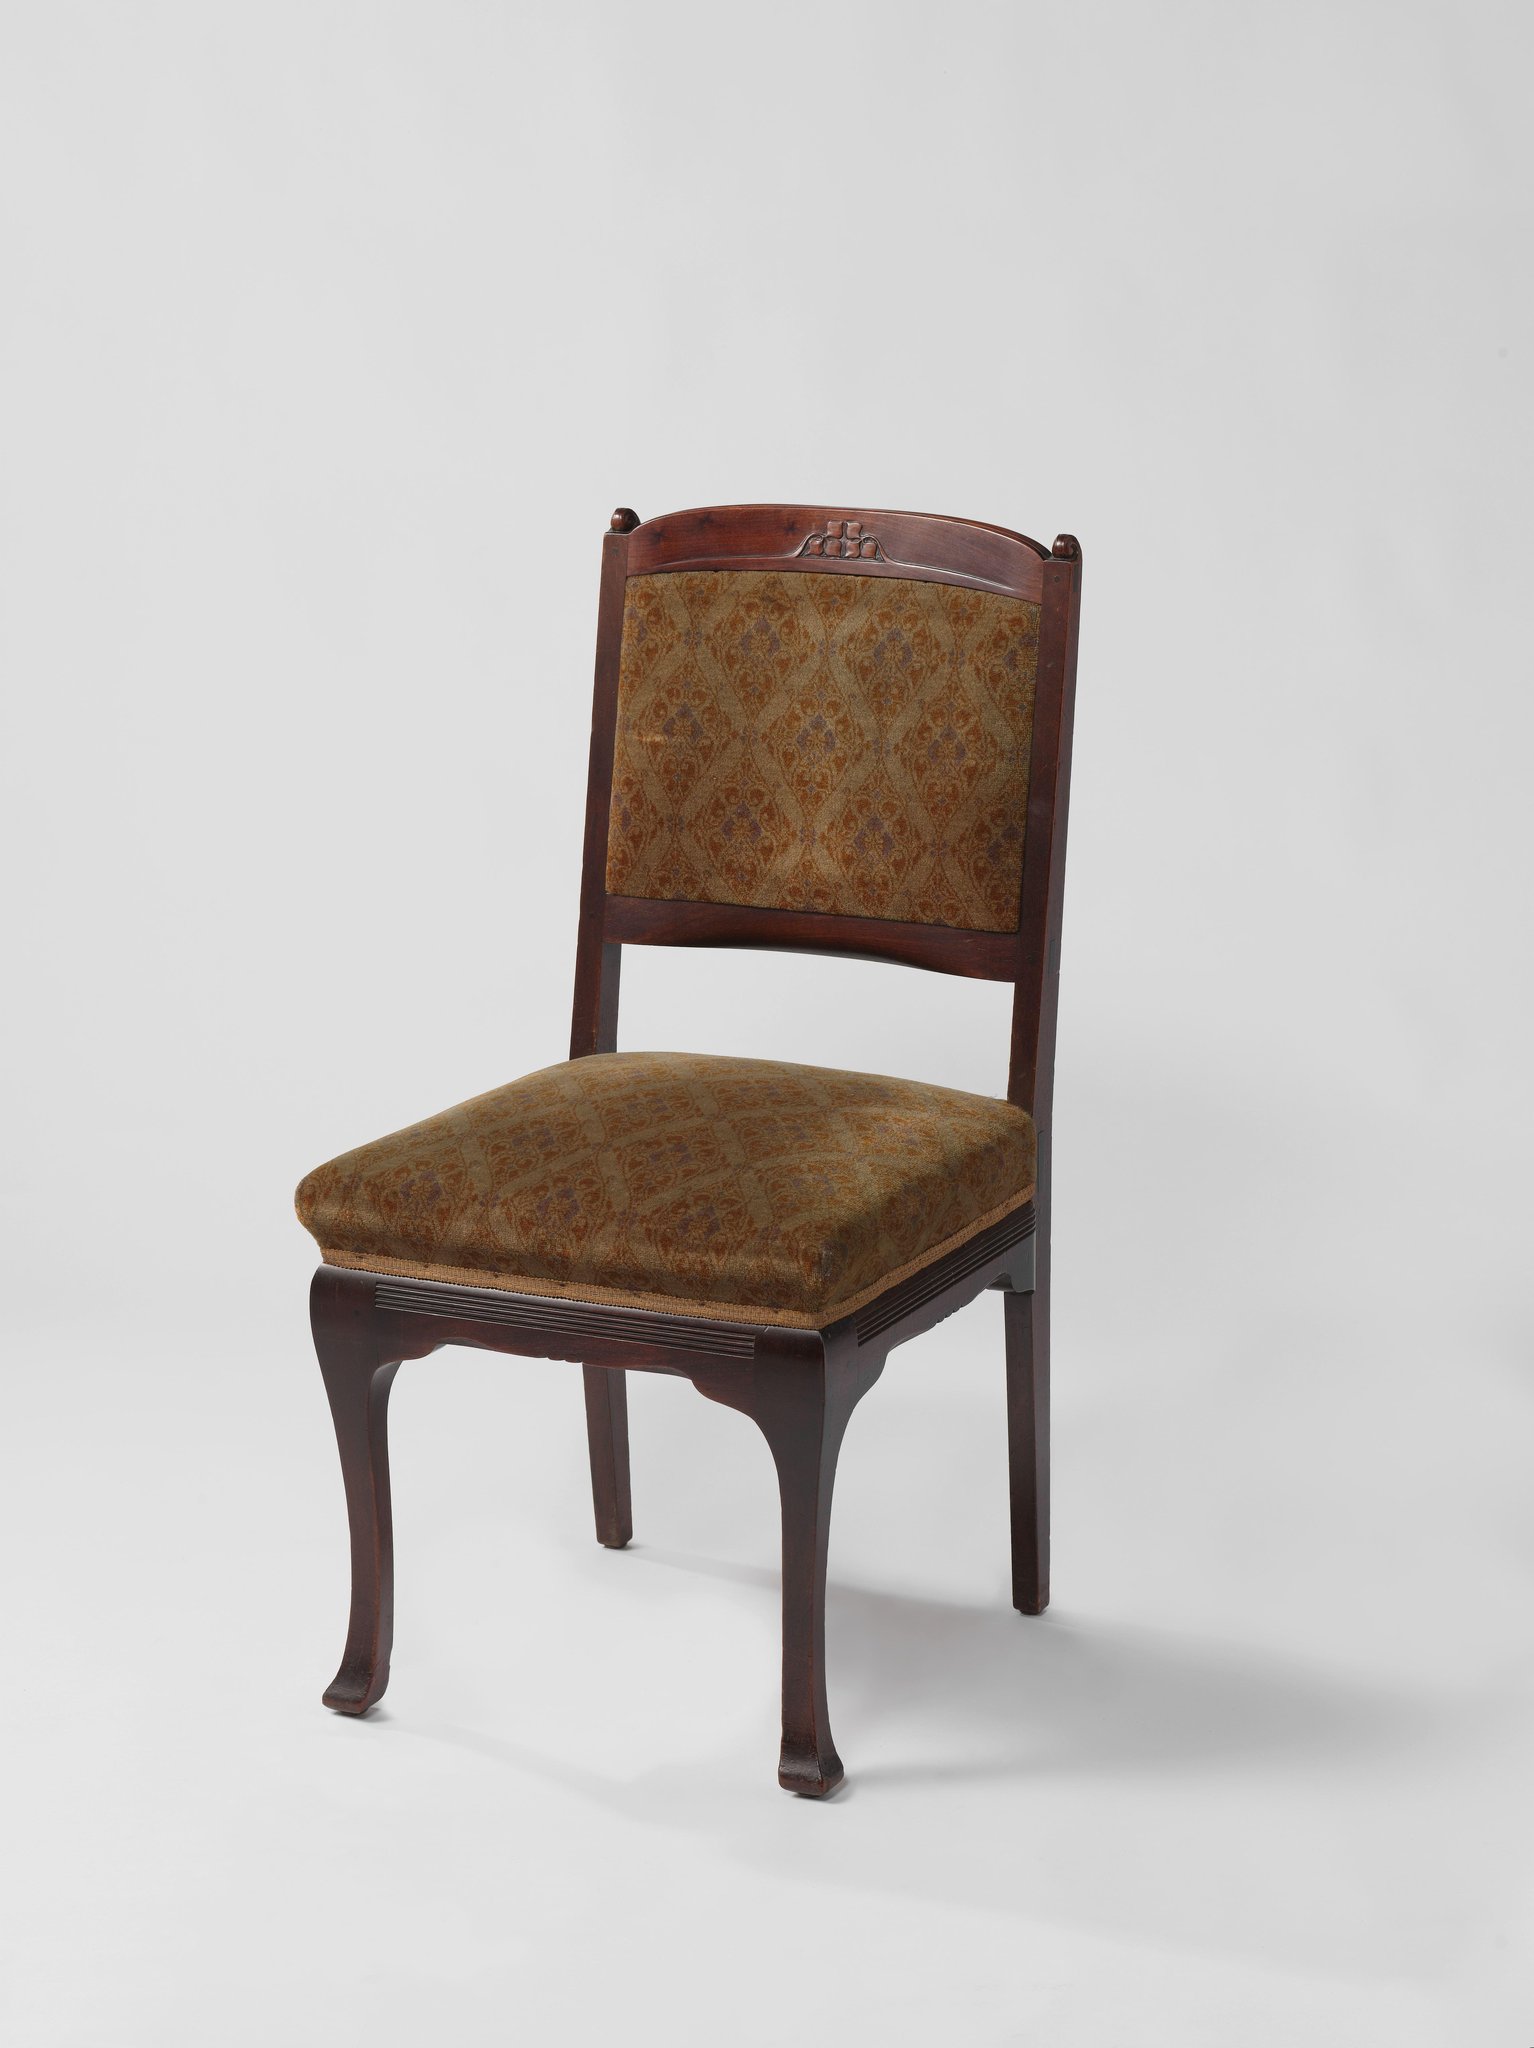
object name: chair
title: Stoel van bruin gebeitst mahoniehout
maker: theo nieuwenhuis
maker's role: designer, draughtsman, print maker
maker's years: 1866-1951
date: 1916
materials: wood, textile, wool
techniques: staining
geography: northern netherlands